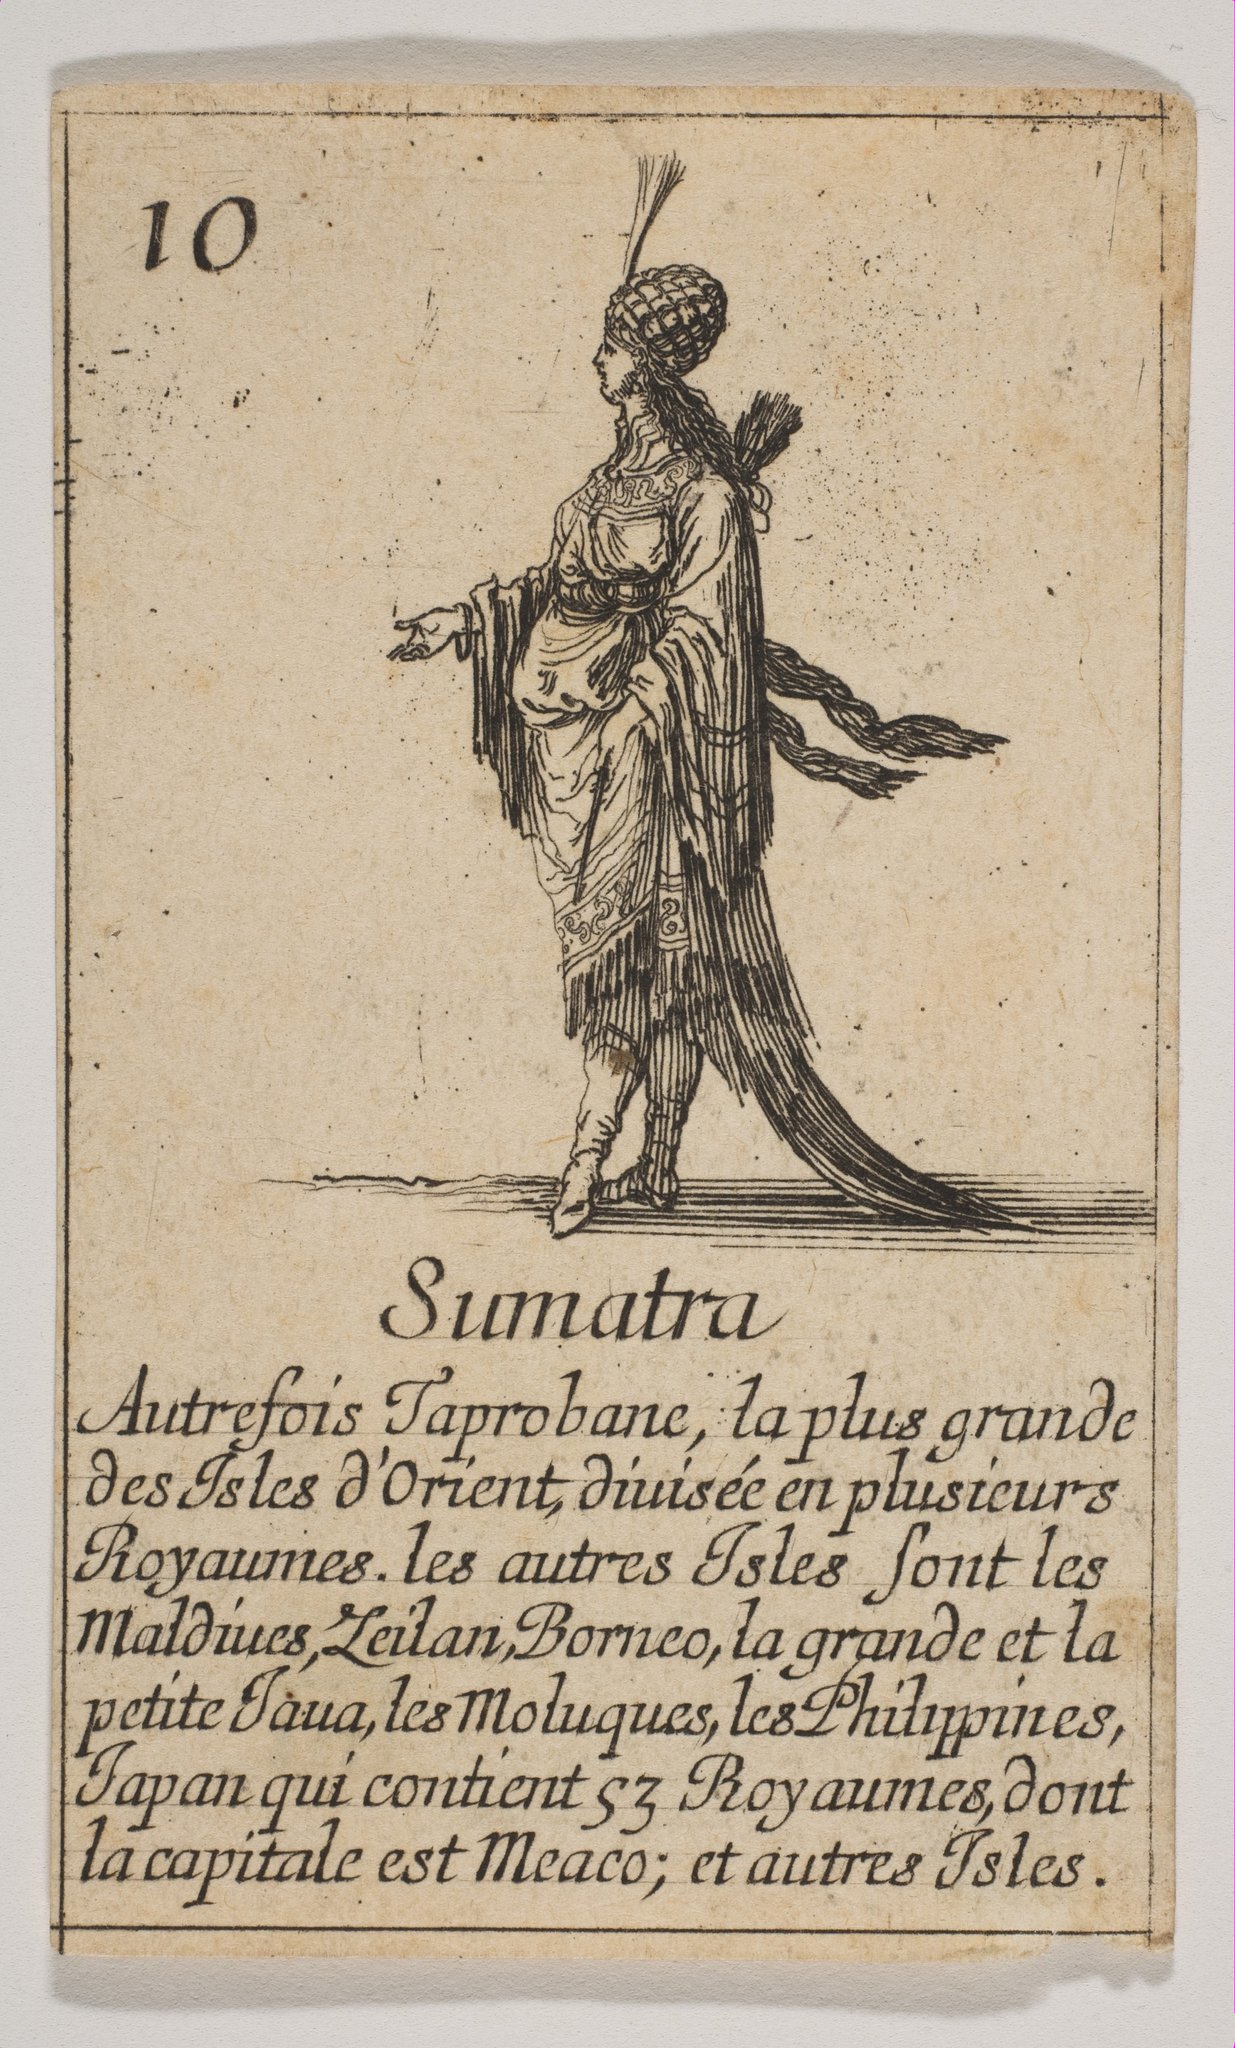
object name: print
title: Sumatra, from "Jeu de la Géographie"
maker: stefano della bella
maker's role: artist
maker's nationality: italian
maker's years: 1610-1664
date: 1644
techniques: etching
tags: women